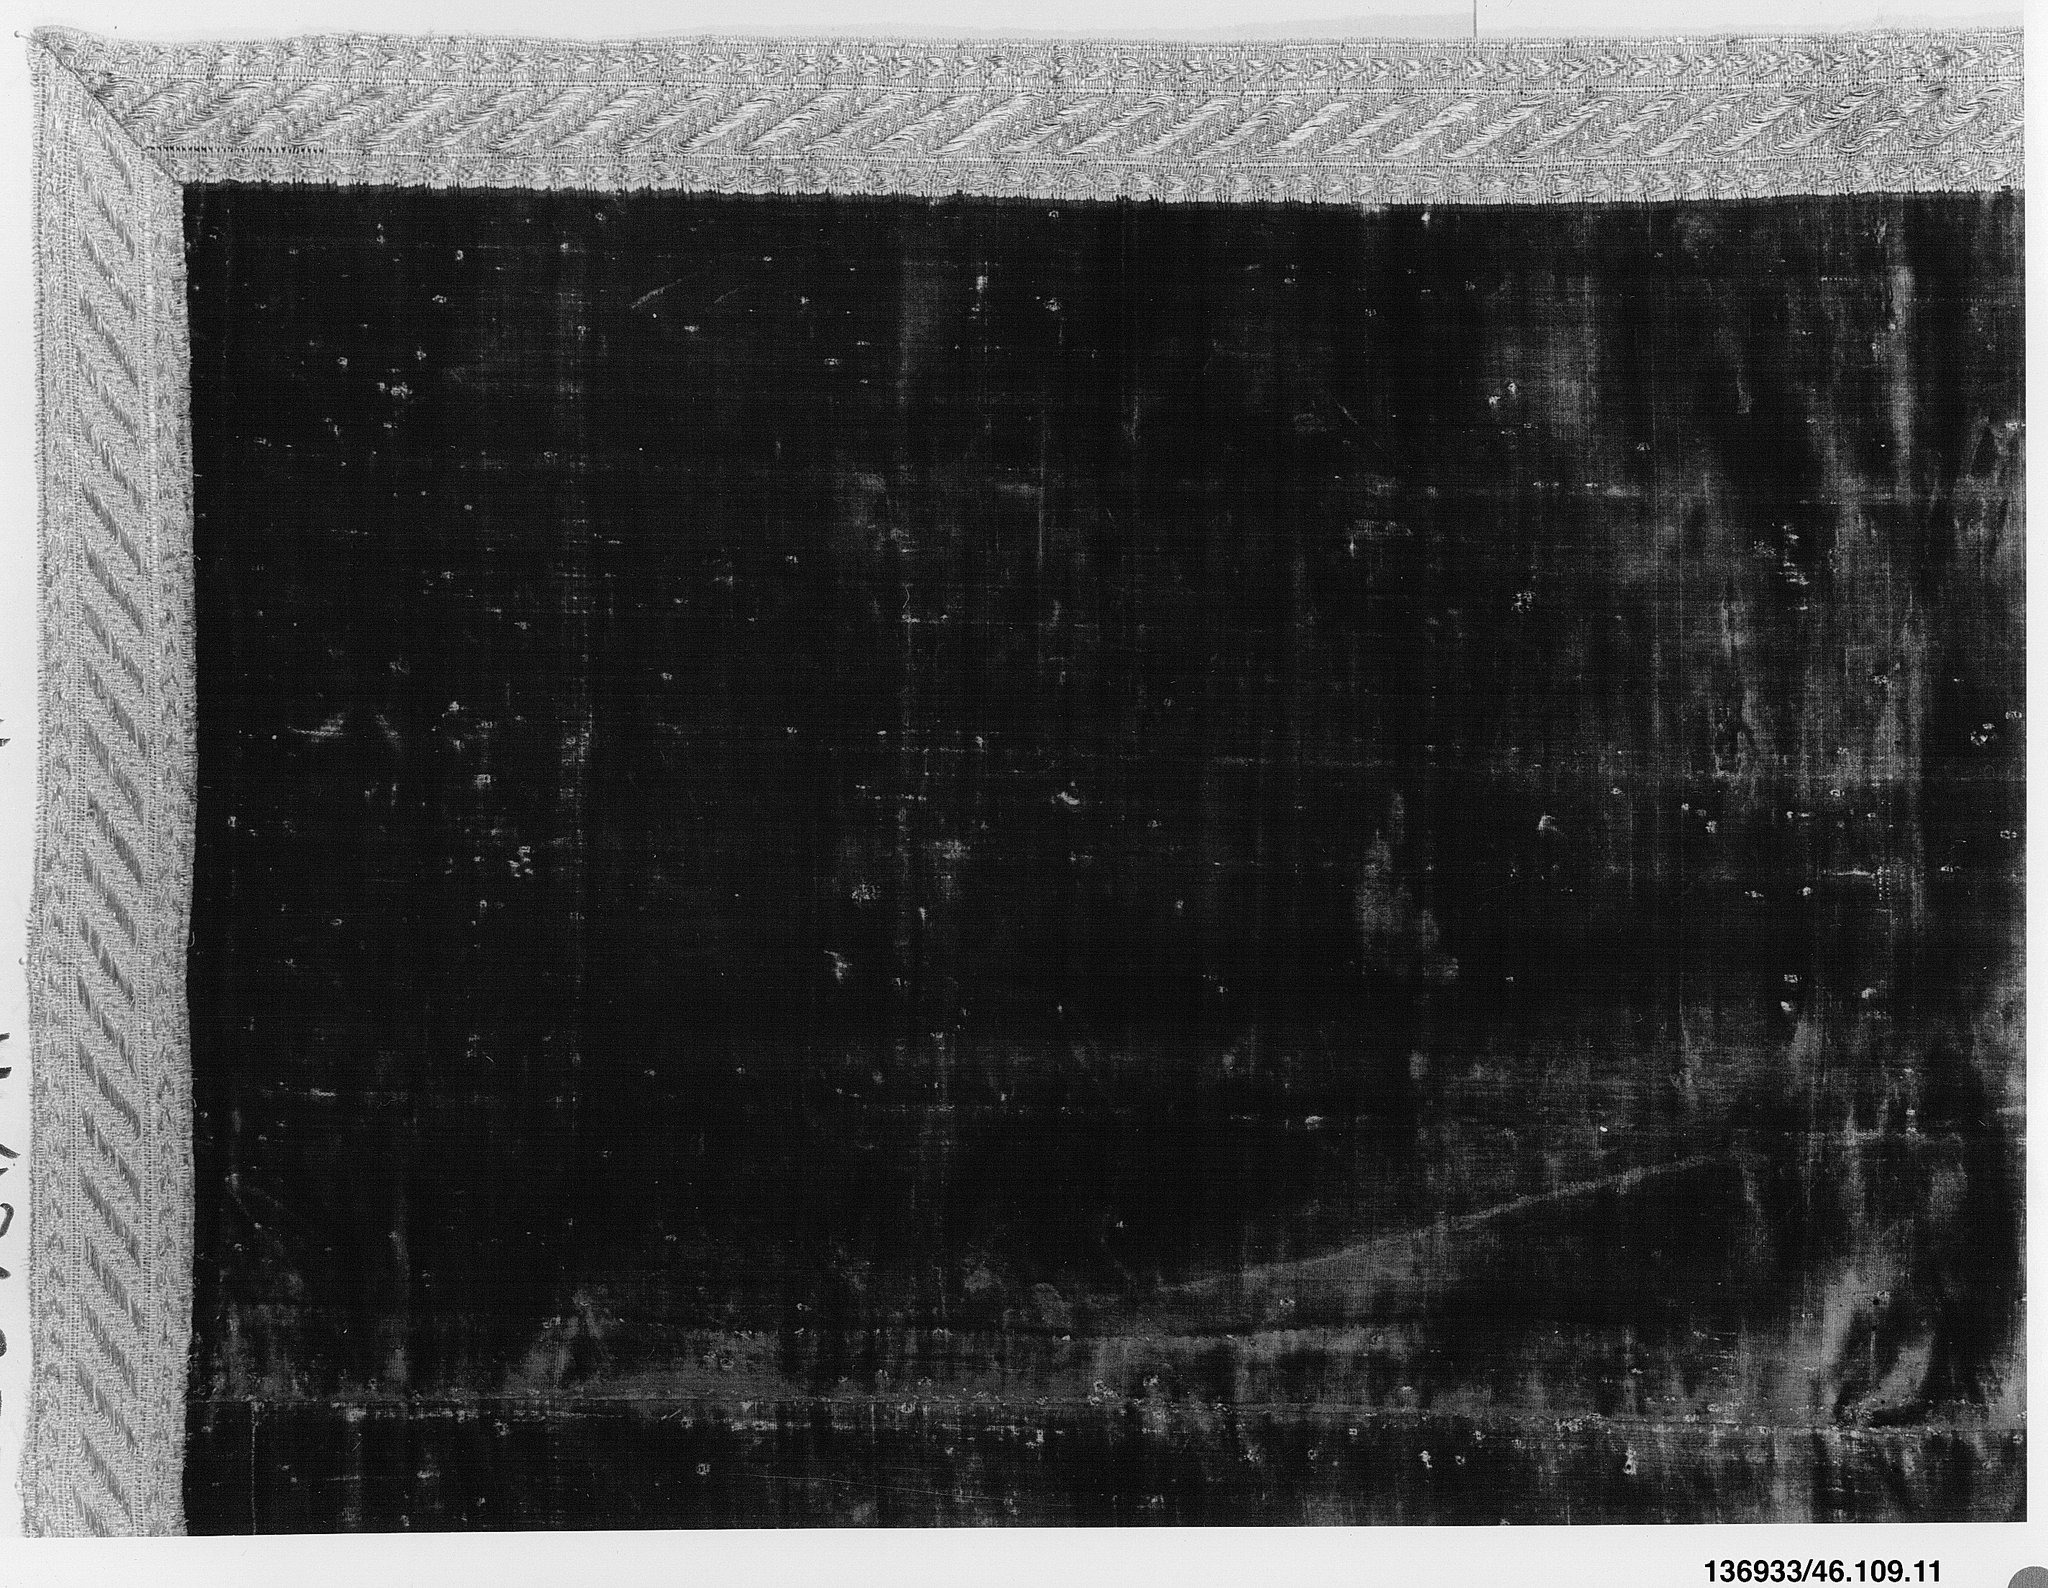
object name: piece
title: Panel of crimson velvet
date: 1567-1633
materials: silk